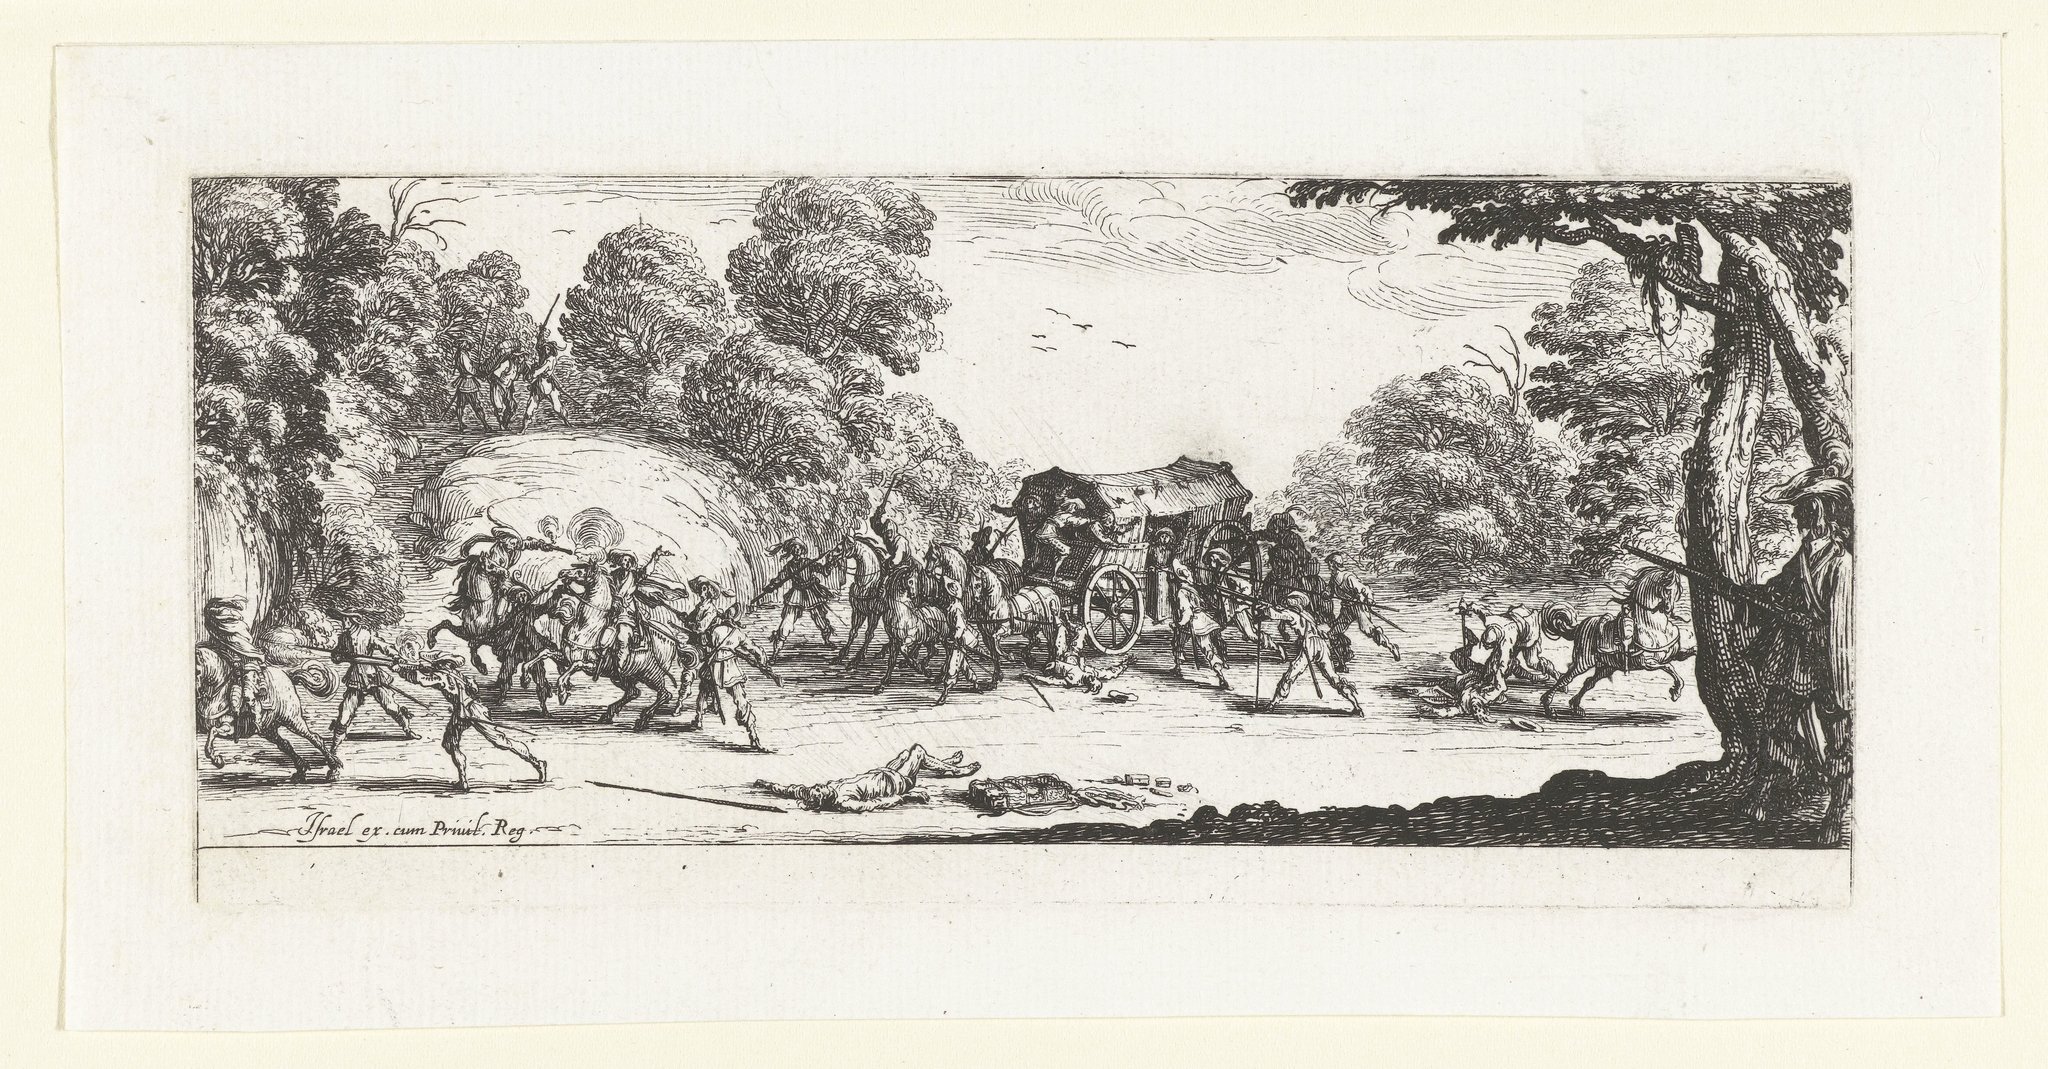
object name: print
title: Soldaten overvallen reizigers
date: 1633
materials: paper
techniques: etching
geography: paris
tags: traveller(s) attacked by robber(s), plundering ~ soldiers, soldiers and civilians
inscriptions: collector's mark: Lugt 240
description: Op een weg door een bos worden reizigers in een koets, ruiters en wandelaars met bepakking overvallen door soldaten. Onder de voorstelling een lege marge. Deze prent is onderdeel van een serie van 17 (18 incl. titelprent) prenten met voorstellingen van diverse soorten ellende die oorlogvoering met zich meebrengt.